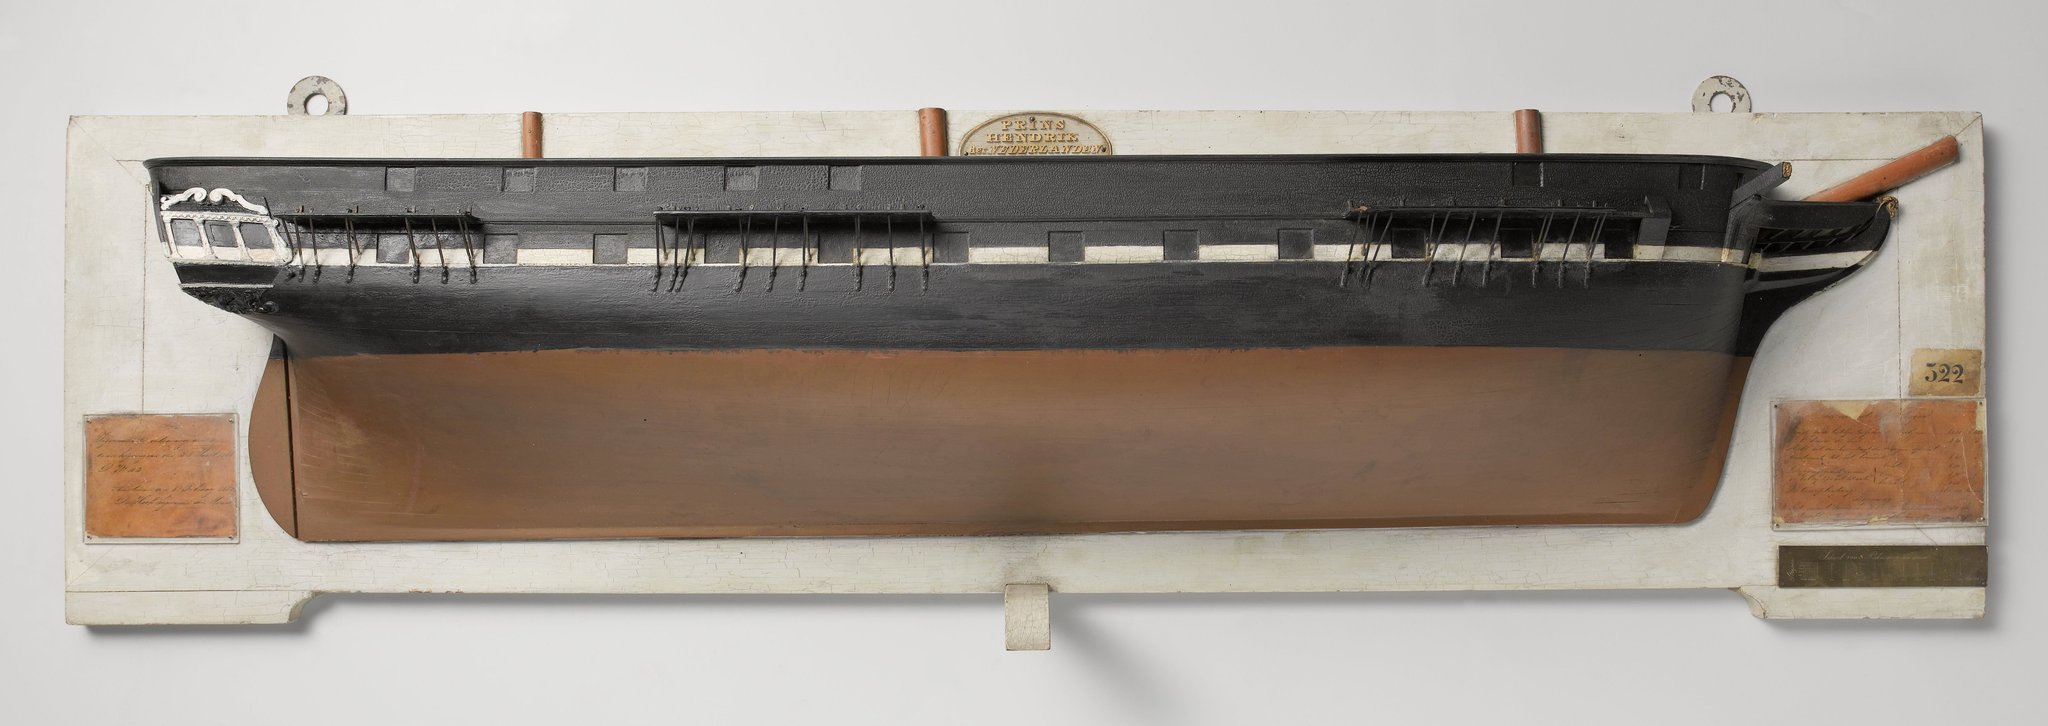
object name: ship model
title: Half model of a 38-gun frigate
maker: Anonymous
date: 1828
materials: brass, wood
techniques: polychromy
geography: netherlands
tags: prins hendrik der nederlanden (schip), prinses sophia (schip)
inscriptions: inscription, bottom left, on a piece of paper, in ink: ‘Ingezonden ter voldoening aan de / aanschrijving van de 3den Maart 1846 / D.N. 103 / Amsterdam den 8 Februari 1851. / De Hoofdingenieur der Marine.’, label, centre right: former inventory label, inscription, top centre, on an oval label: ‘PRINS / HENDRIK / der NEDERLANDEN / FREGAT / Van 38 STUKKEN / (nieuw model)’, scale, bottom right: brass scale in inches, inscription, bottom right, on a piece of paper, in ink: ‘Voornaamste afmetingen. / [followed by measurements and armament]’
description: Het fregat van 38 stukken de Prins Hendrik der Nederlanden, lang 48 m, werd door J. Vos in 1844-1847 in Amsterdam gebouwd. Zij was een prototype volgens de ontwerp-principes van Sir William Symonds, die een teleurstelling bleken. Er werden dan ook maar enkele schepen naar Symonds principes in Nederland gebouwd, waaronder het zusterschip de Prinses Sophia. In 1859 werd de Prins Hendrik omgebouwd tot drijvende batterij en herdoopt Pollux, maar als zodanig nooit in gebruik genomen en afgevoerd in 1860. Tot voor kort werd de drijvende batterij Pollux verward met de Olifant.